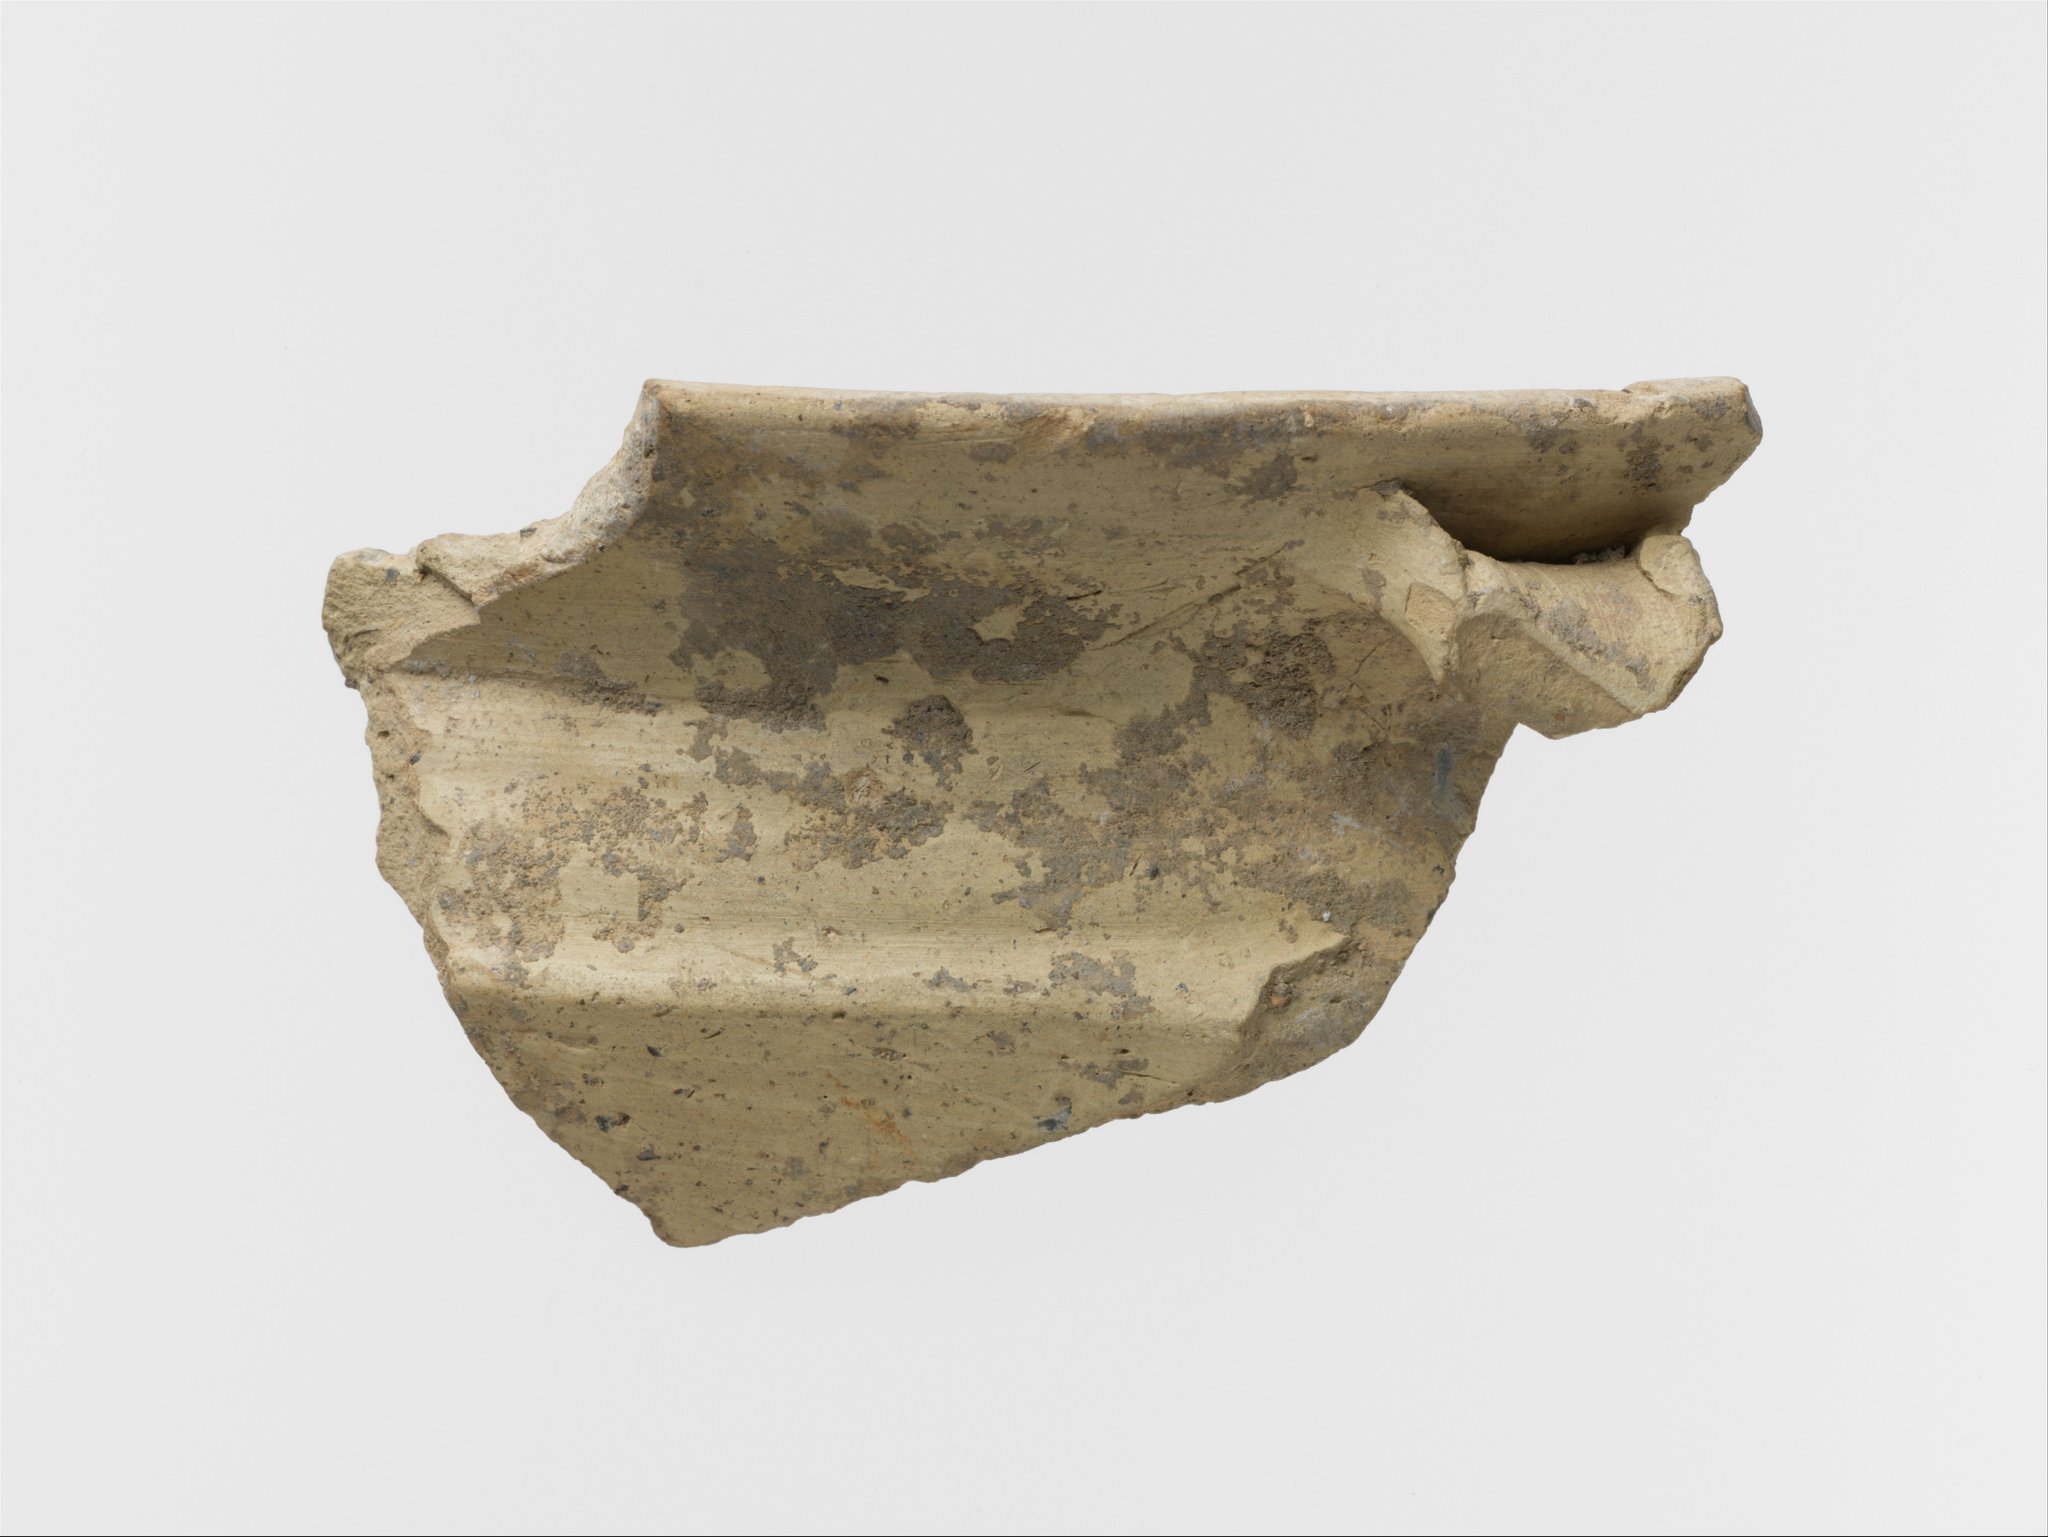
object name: vase fragment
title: Terracotta rim of a vase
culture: helladic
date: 2000-1550 BCE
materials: terracotta